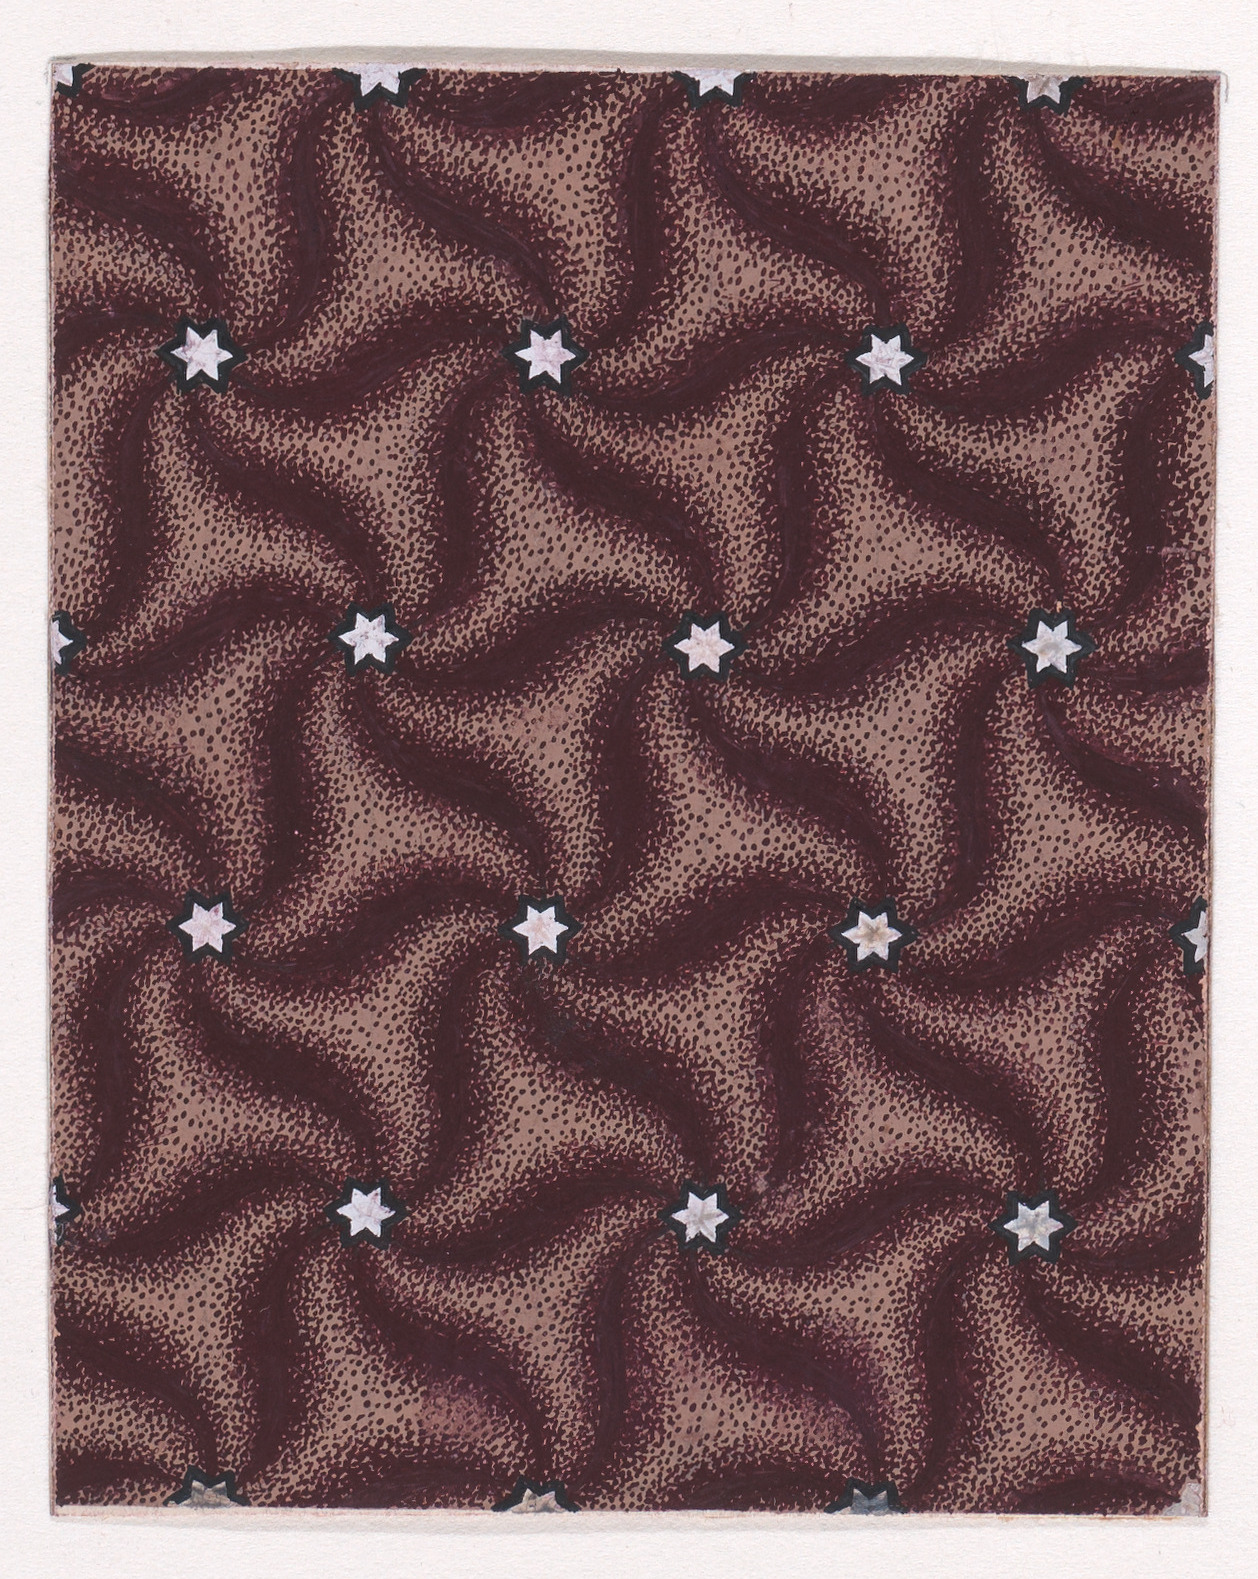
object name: drawing ornament architecture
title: Textile Design with a Seamless Pattern of Swirls Decorated with Haxagrams over a Stippled Background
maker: anonymous, alsatian, 19th century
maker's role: artist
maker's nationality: alsatian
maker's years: 1800-1900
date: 1840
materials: gouache